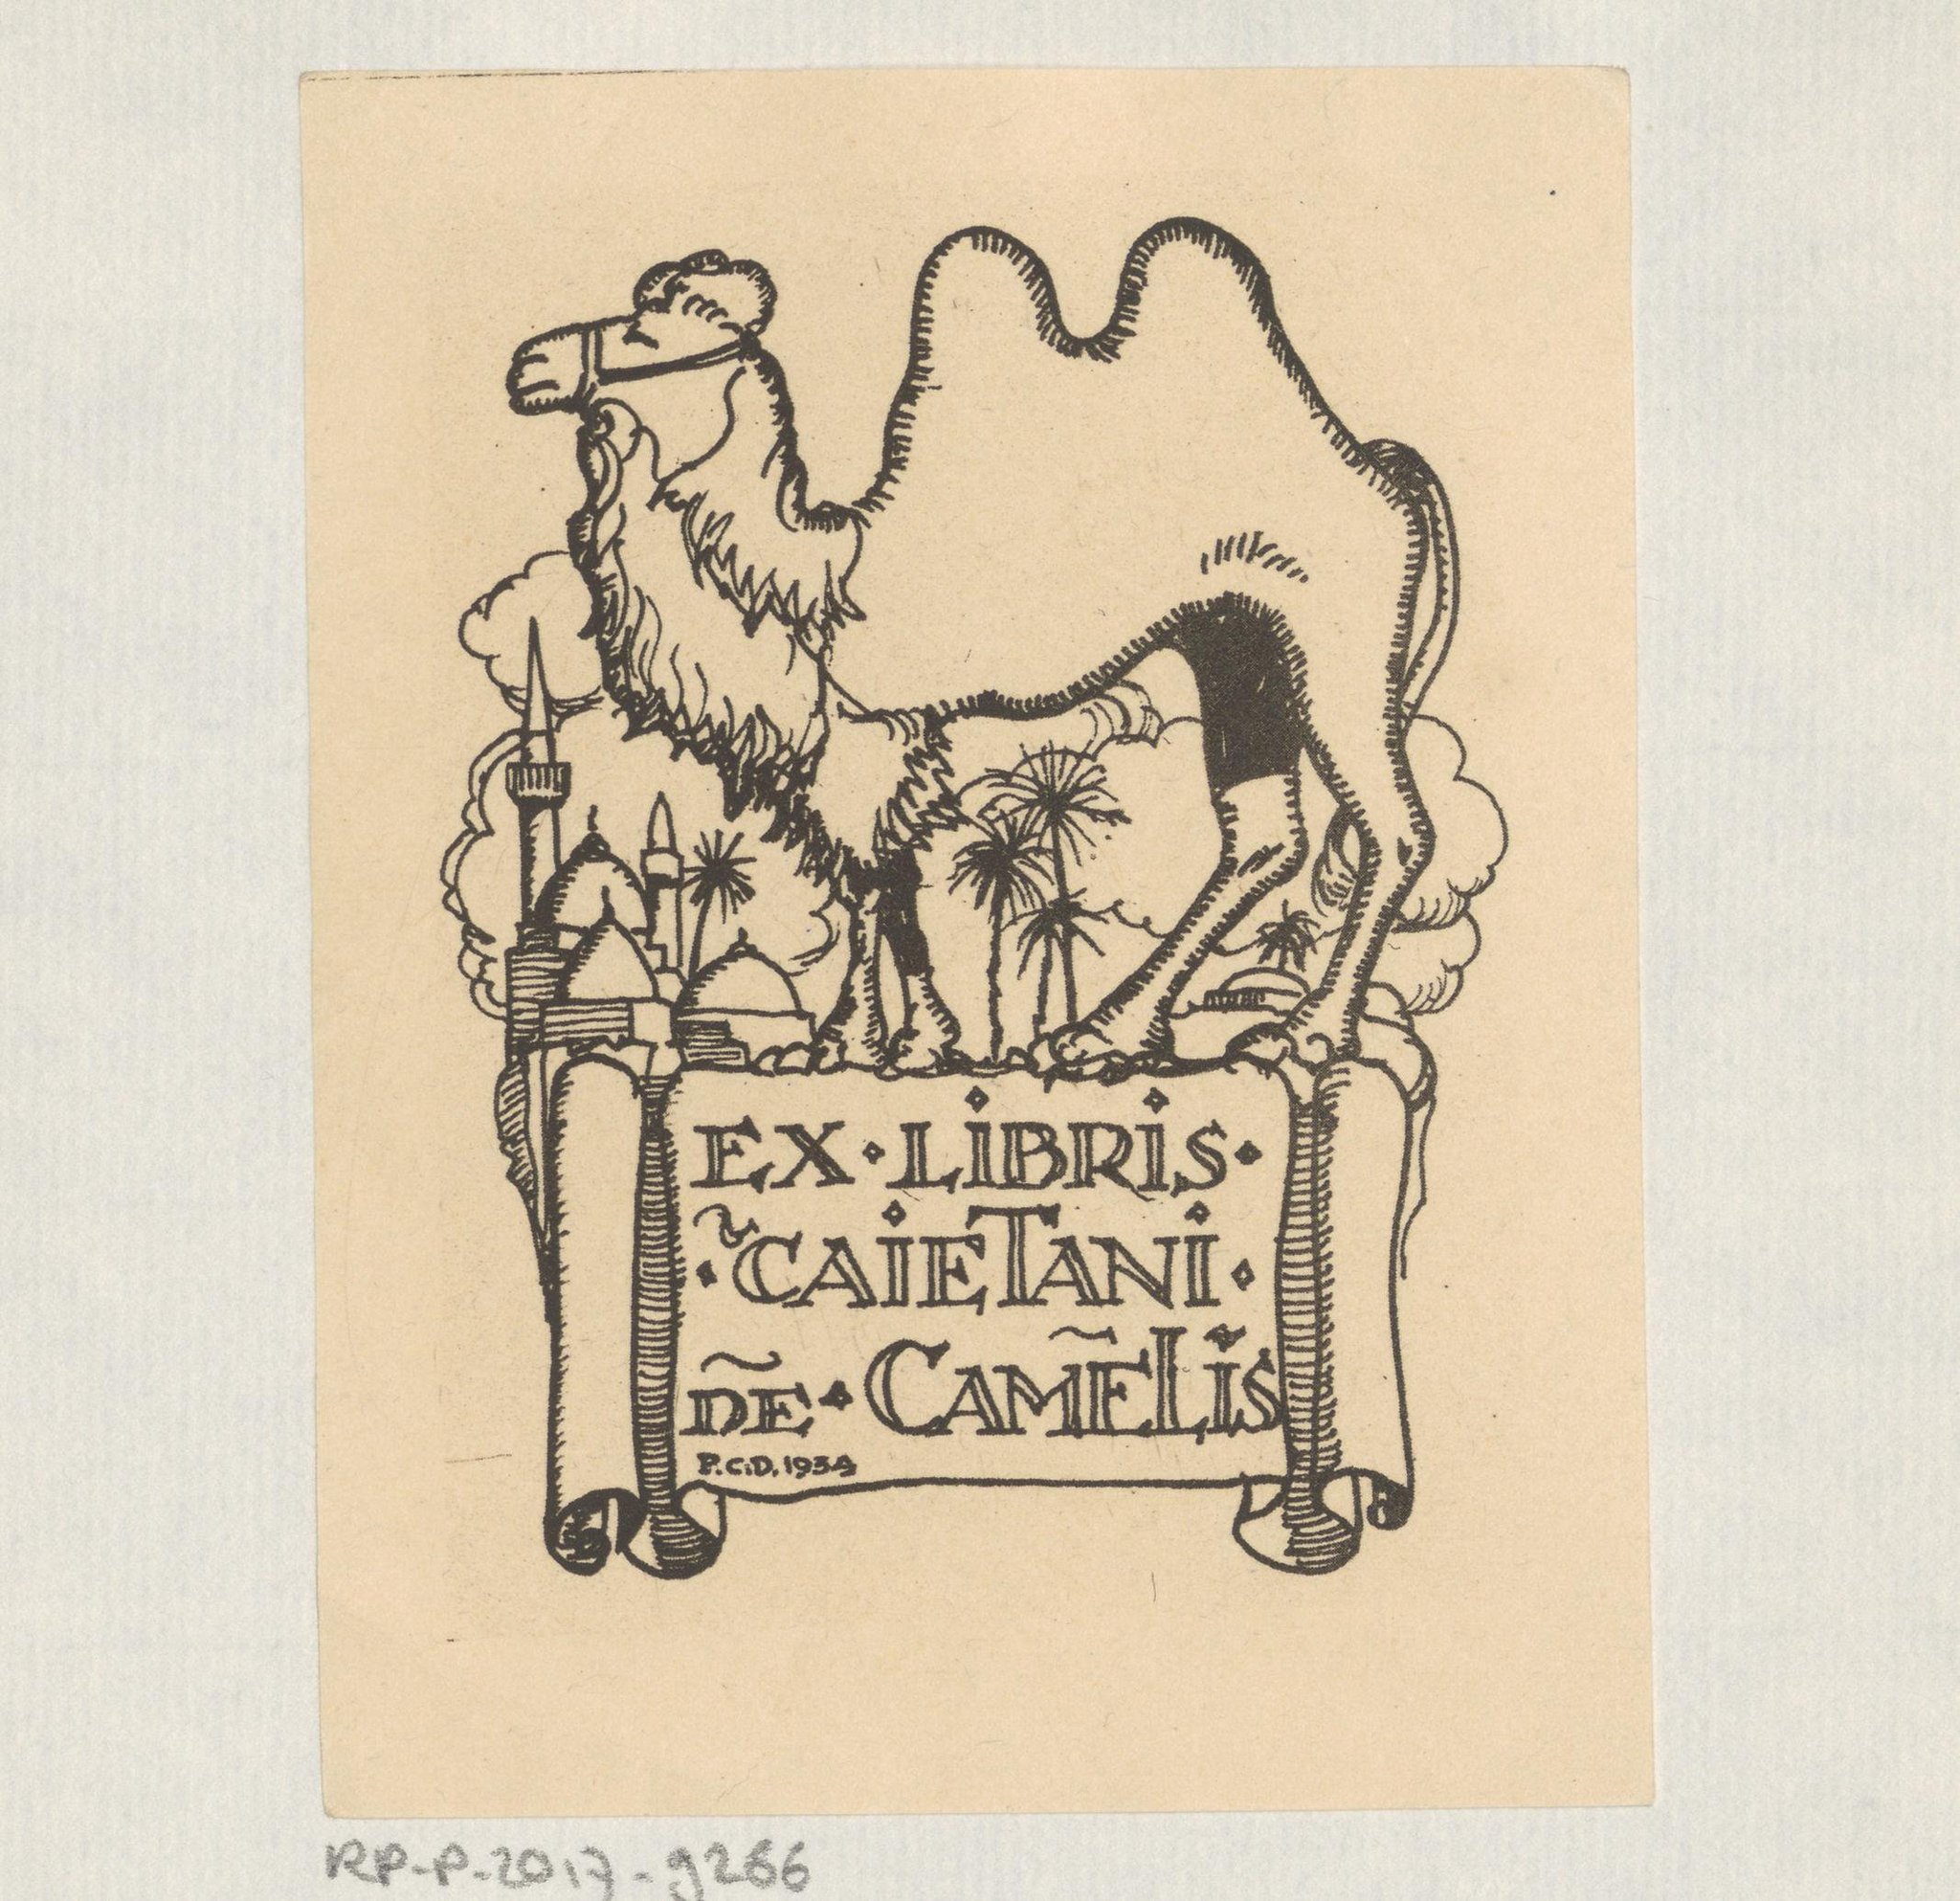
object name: bookplate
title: Ex libris Caietani de Camelis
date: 1934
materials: paper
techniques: printing block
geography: italy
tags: hoofed animals: camel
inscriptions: date